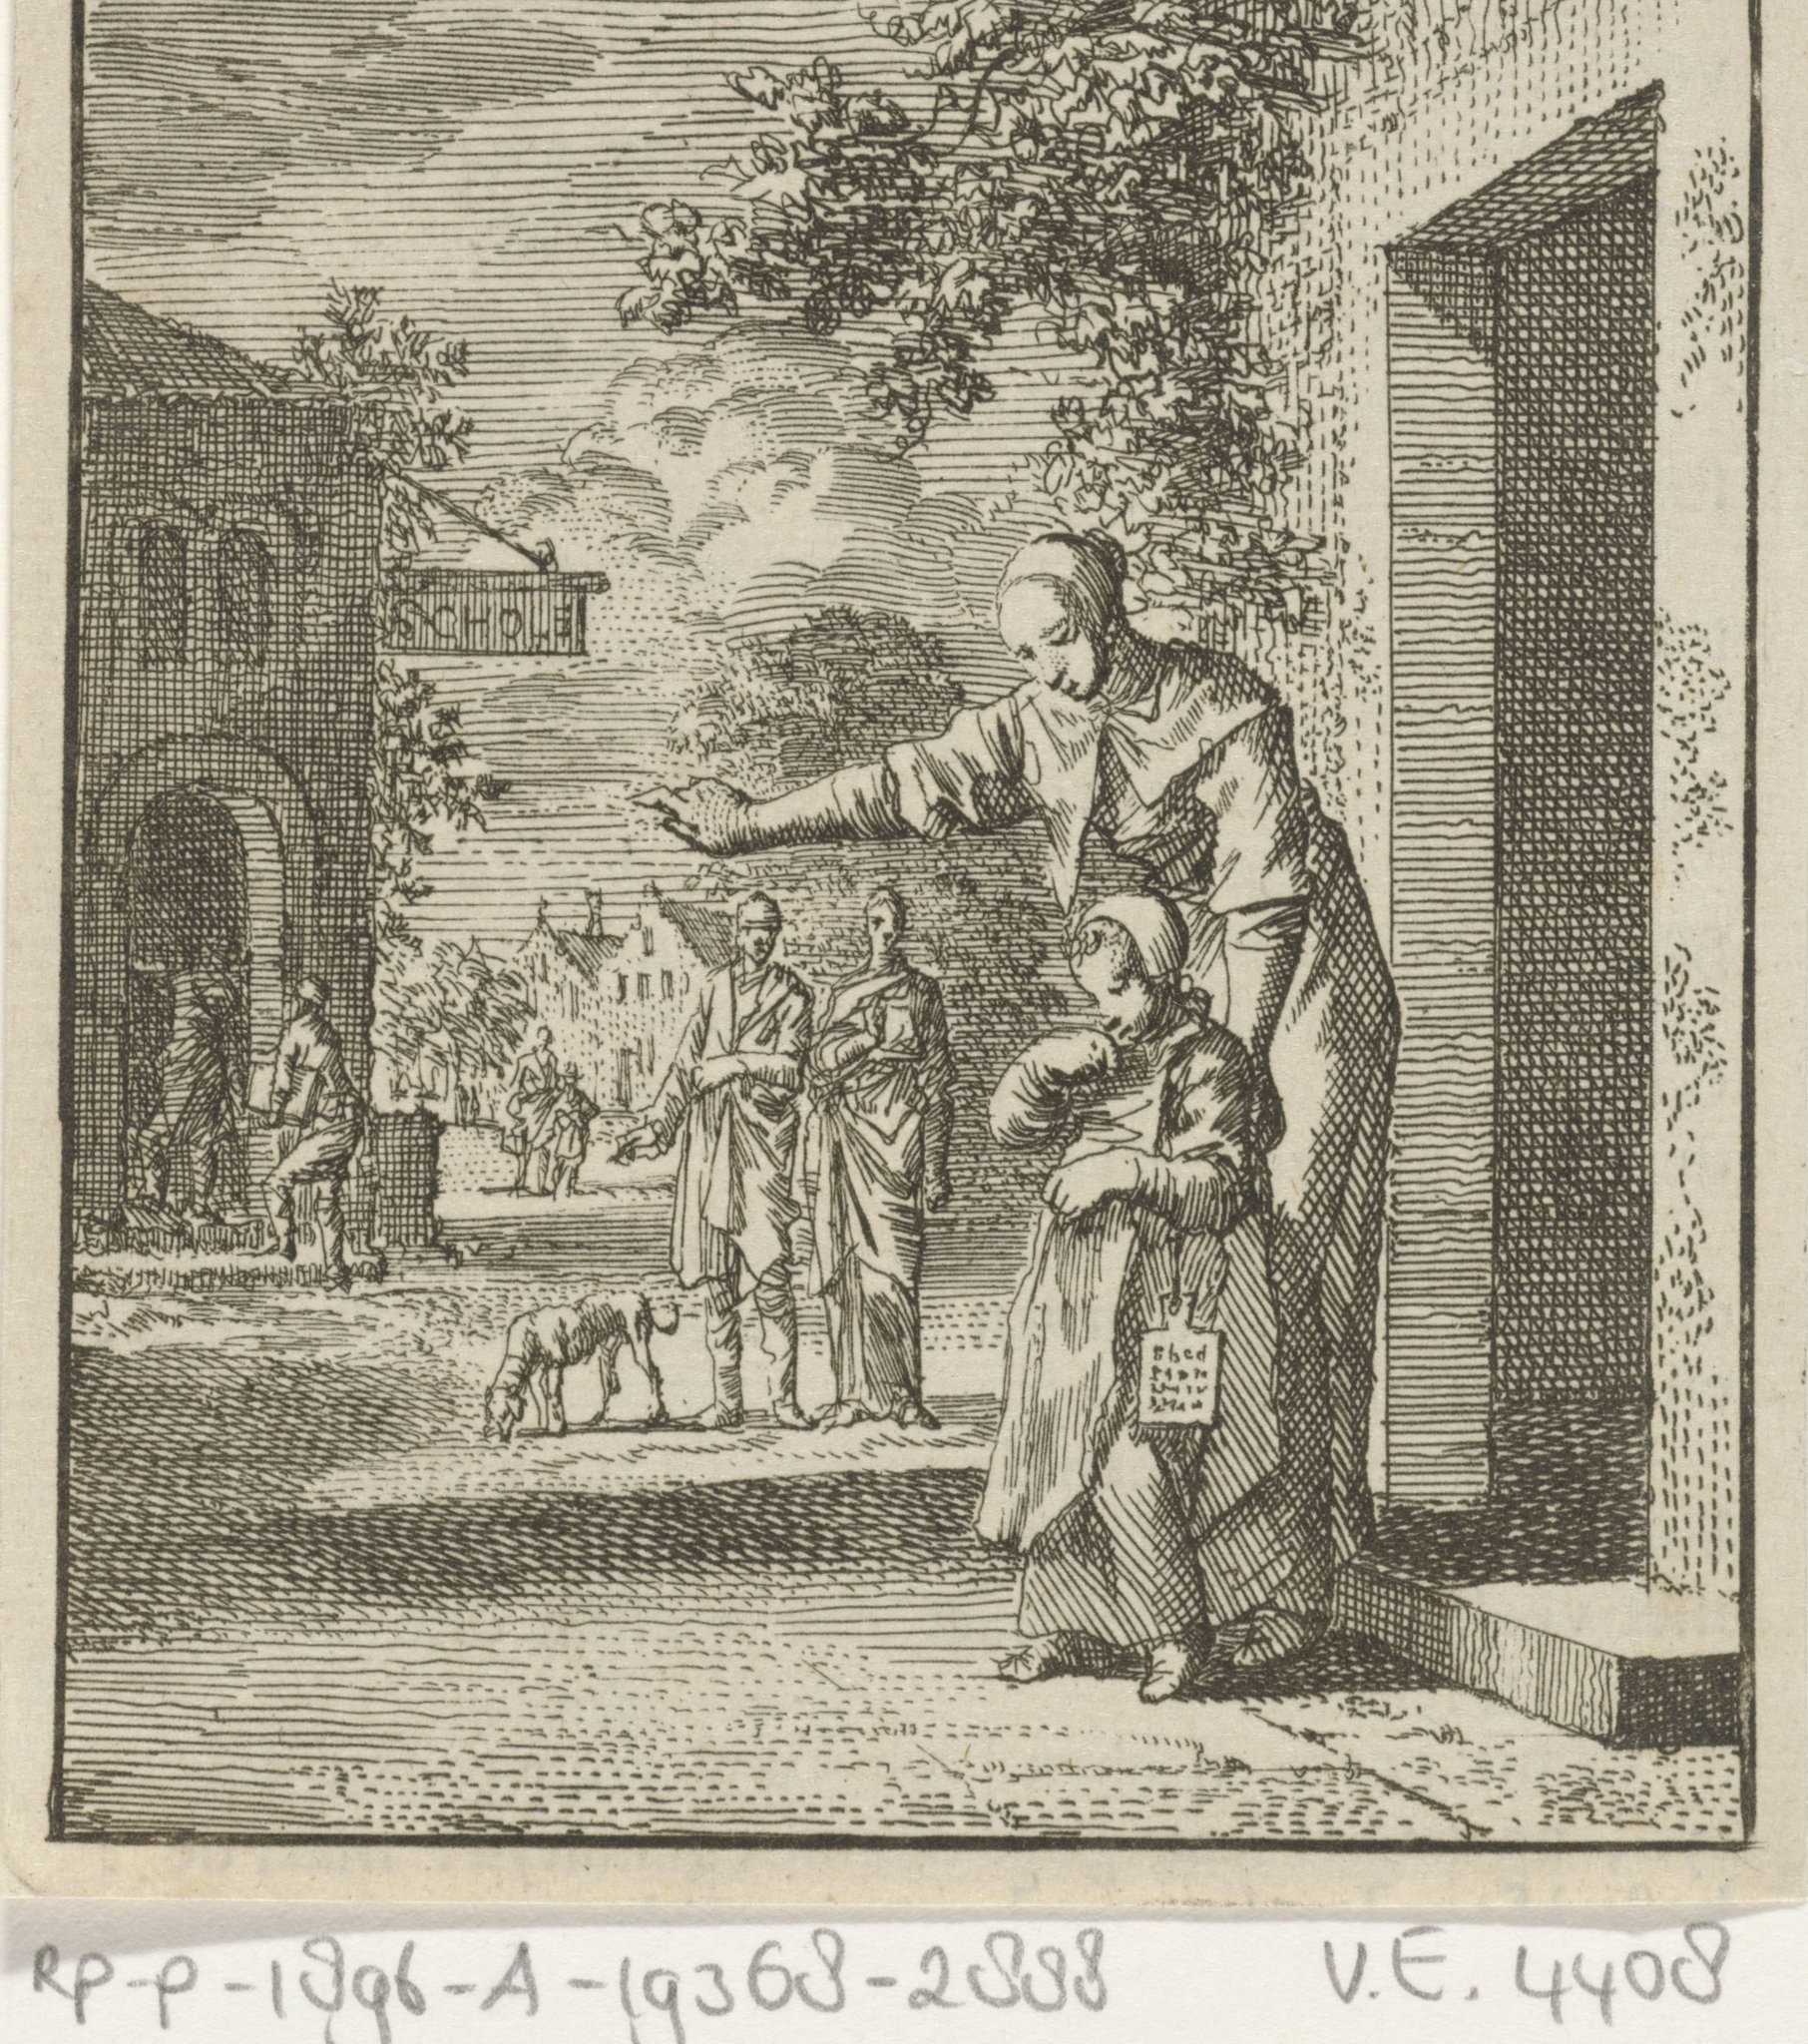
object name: print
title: Het Kindje gaat School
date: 1712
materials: paper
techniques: etching, letterpress printing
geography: amsterdam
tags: mother and baby or young child, being brought to school, first school-day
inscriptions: collector's mark: Lugt 2228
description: Illustratie uit: Luyken, Jan. Des menschen begin, midden en einde. Amsterdam: Wed. Pieter Arentsz II en Cornelis van der Sys, 1712, p. 41.